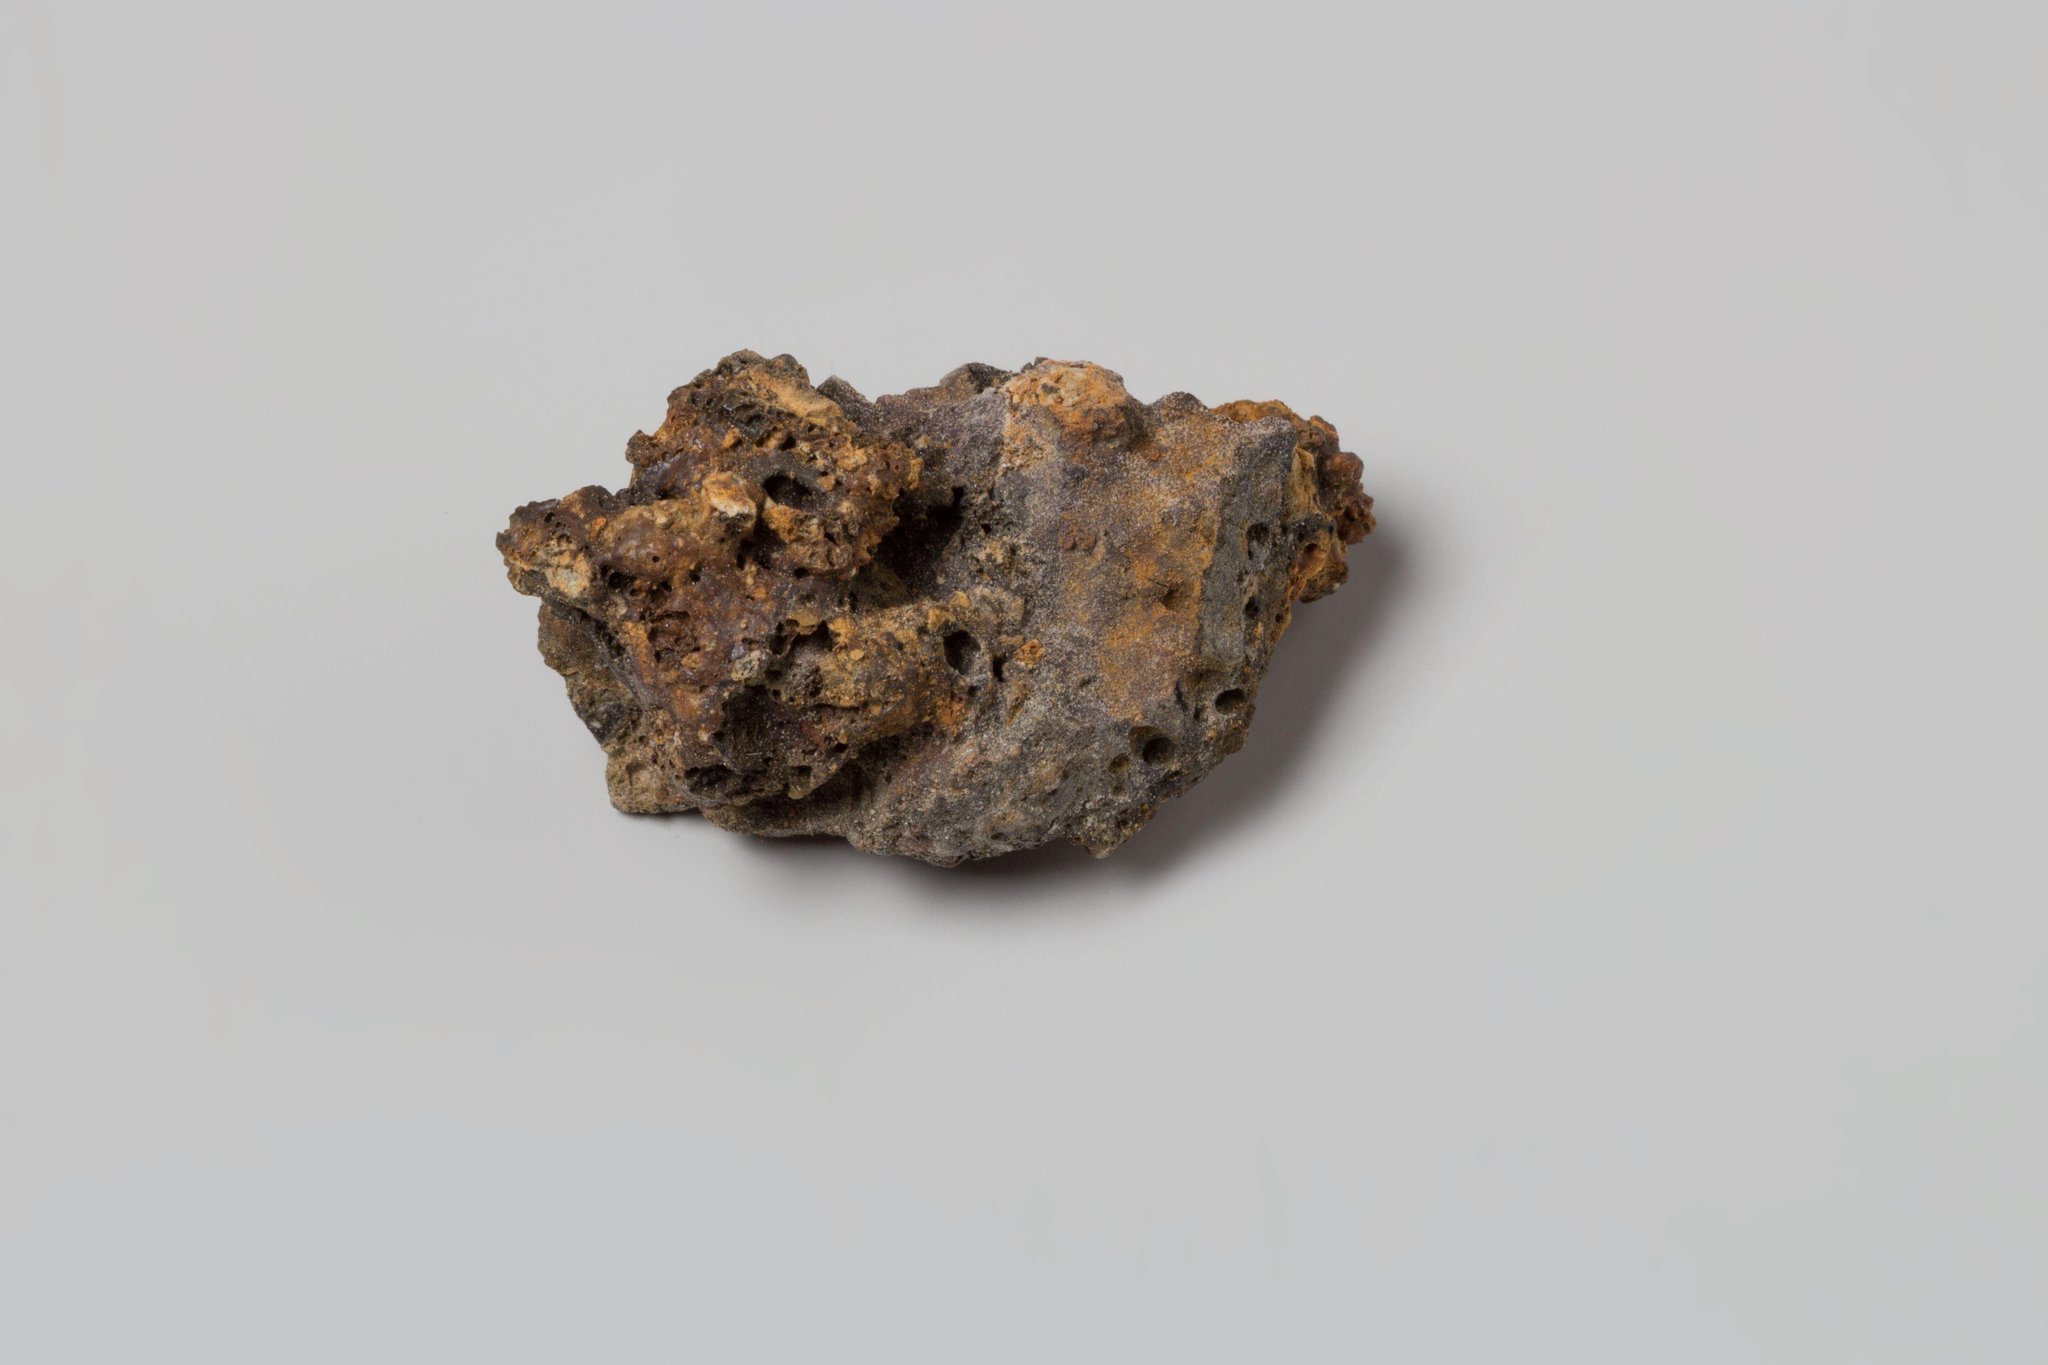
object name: slag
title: Restafval van steenkool uit het wrak van de Oost-Indiëvaarder 't Vliegend Hart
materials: mineral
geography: netherlands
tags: 't vliegend hart (schip), verenigde oostindische compagnie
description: Steenachtige brok restafval van de verbranding van steenkool. Eén stuks. Slug.